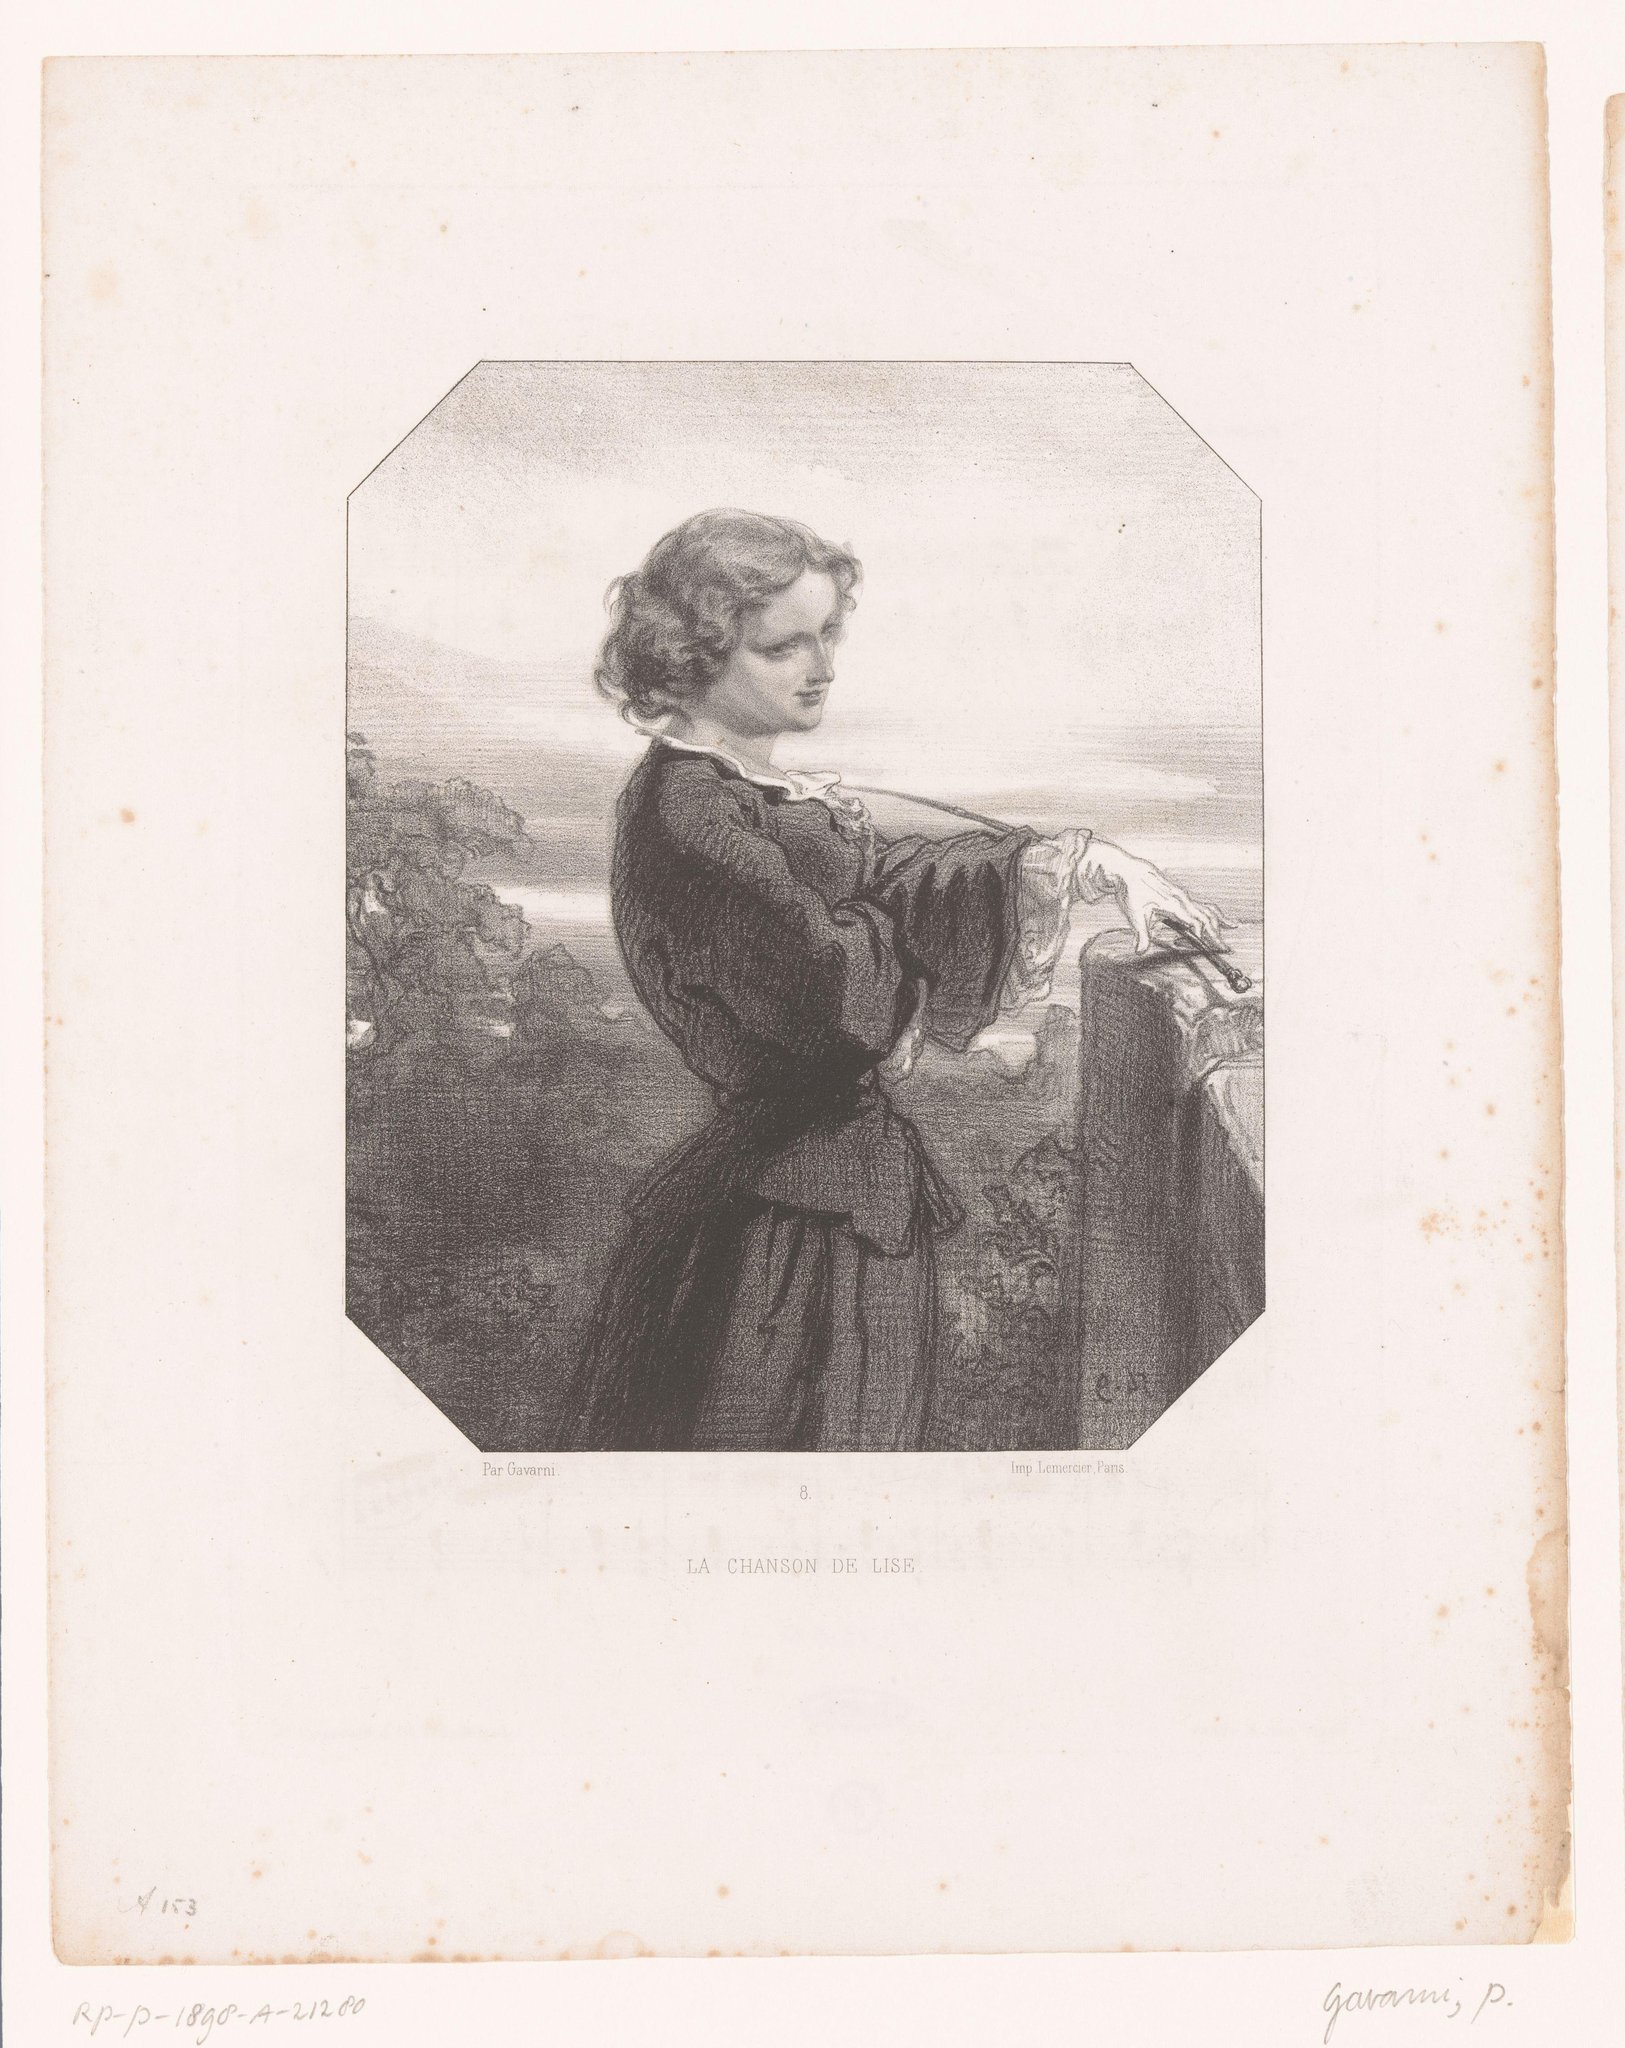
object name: print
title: Illustraties bij de liederen van Jeanne Gavarni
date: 1854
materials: paper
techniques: lithograph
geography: paris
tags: adolescent, young woman, maiden, clothes for special purposes, whip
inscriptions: collector's mark: Lugt 964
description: Illustratie bij het Chanson de Lise van G. de C. en Jeanne Gavarni.